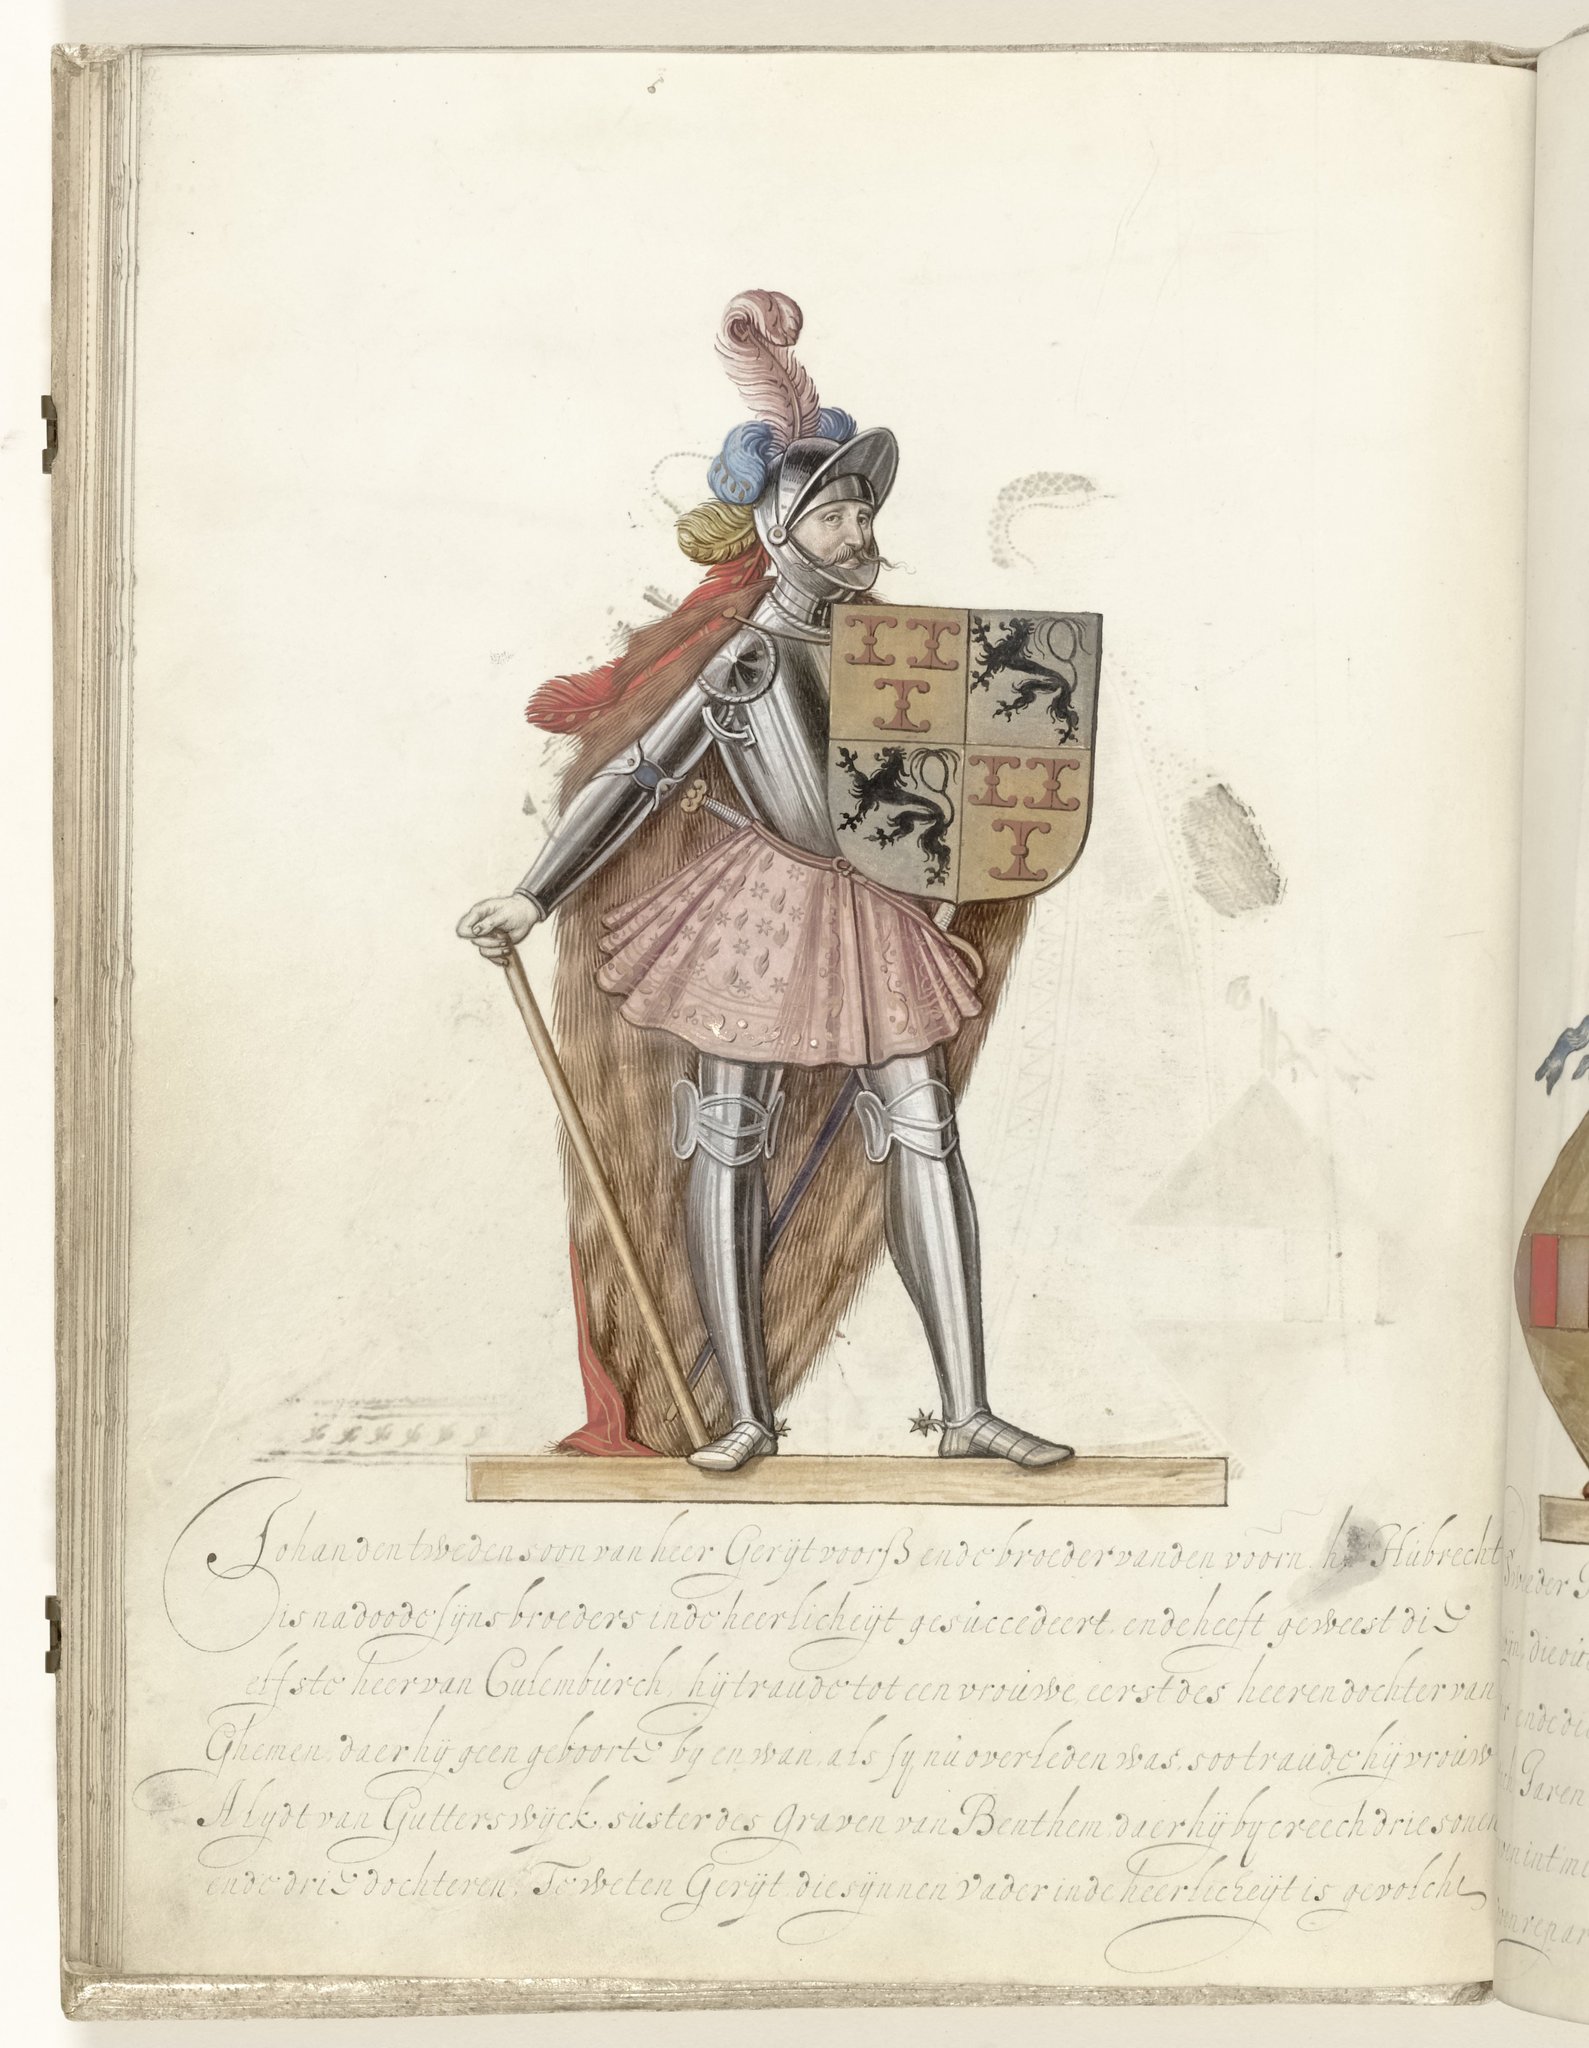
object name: drawing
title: Johan III, heer van Culemborg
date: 1590-1593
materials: paint, gouache, ink, parchment, watercolor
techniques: writing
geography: northern netherlands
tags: culemborg, heren en graven van, johan heer van culemborg (iii), culemborg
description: Johan III, elfde heer van Culemborg. Staande ten voeten uit met het gevierendeelde wapen van Culemborg en Van der Leck. In wapenrusting, een staf in de rechterhand het wapen in de linkerthand. Onderdeel van een geïllustreerd handschrift met de genealogie van de heren en graven van Culemborg.